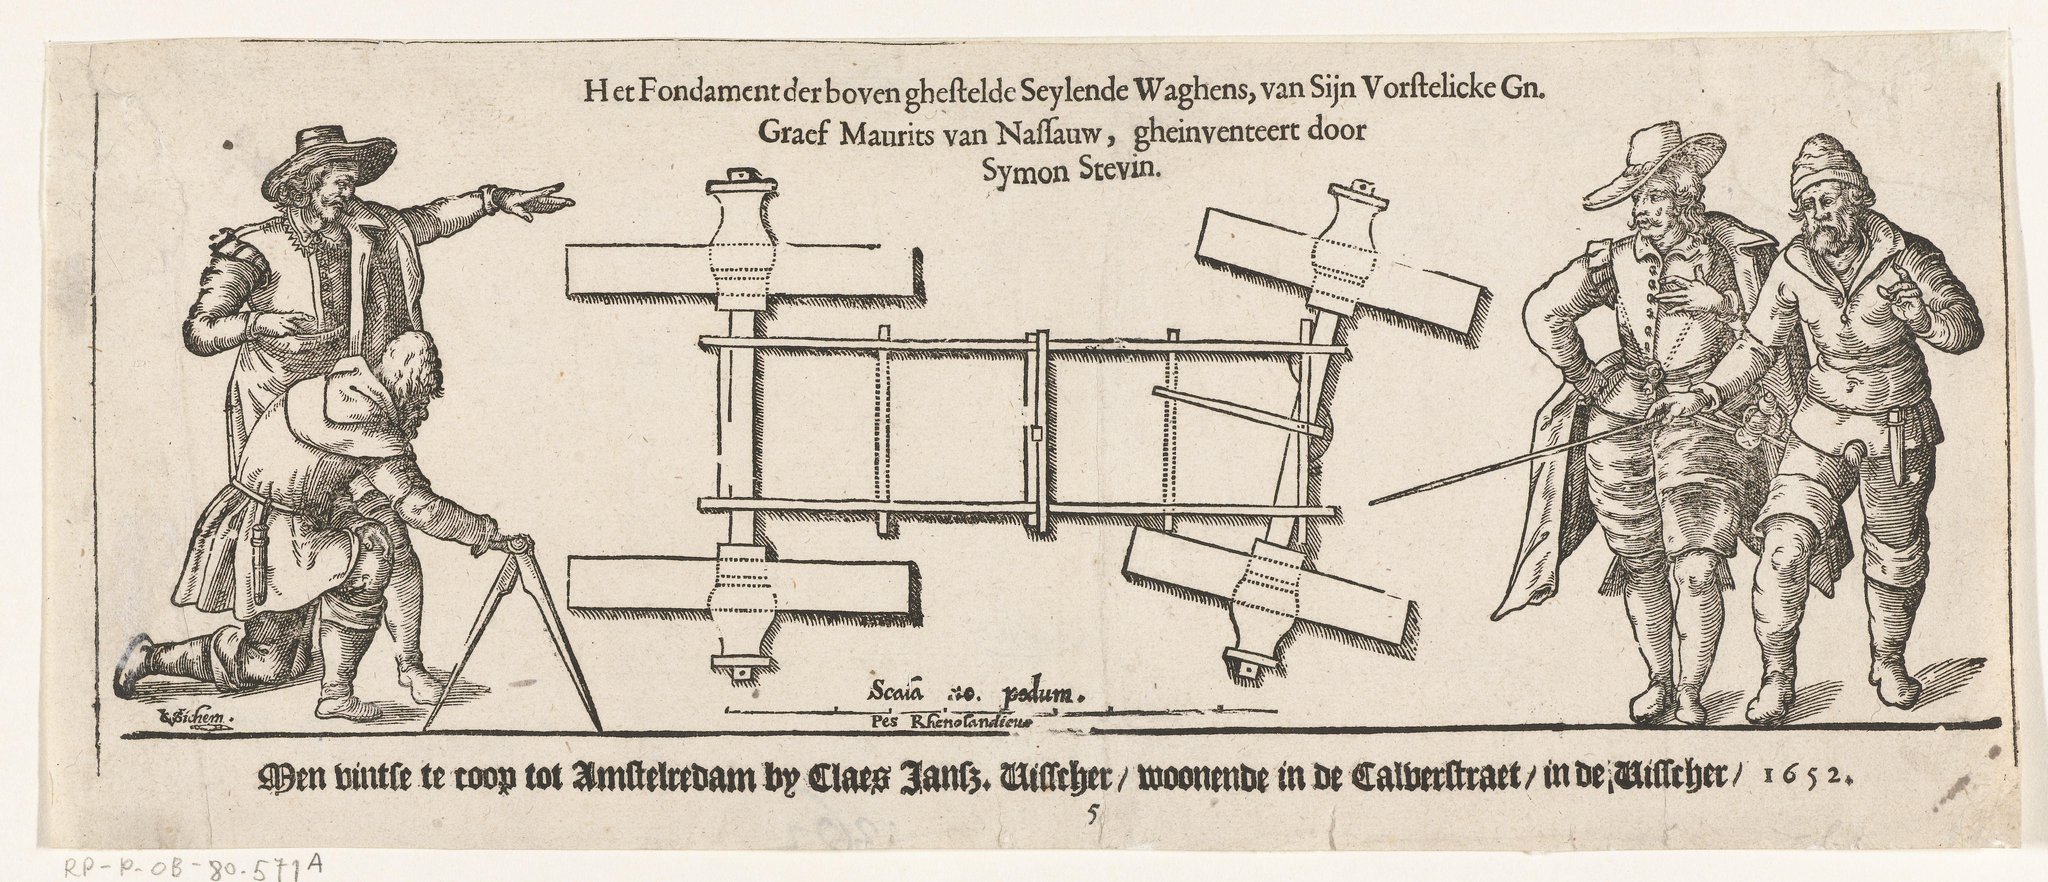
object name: print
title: Diagram van de zeilwagen van Simon Stevin, 1602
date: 1603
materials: paper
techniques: letterpress printing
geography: amsterdam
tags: maurice (prince of orange), simon stevin, sailing-car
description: Diagram van de zeilwagen van Simon Stevin met aan weerszijden twee figuren, 1602. Met boven de figuren 3 regels tekst in het Nederlands. Onderdeel genummerd 5. Dit blaaden behoort aan de onderzijde van de grote prent van de zeilwagen in drie platen gemonteerd te worden.